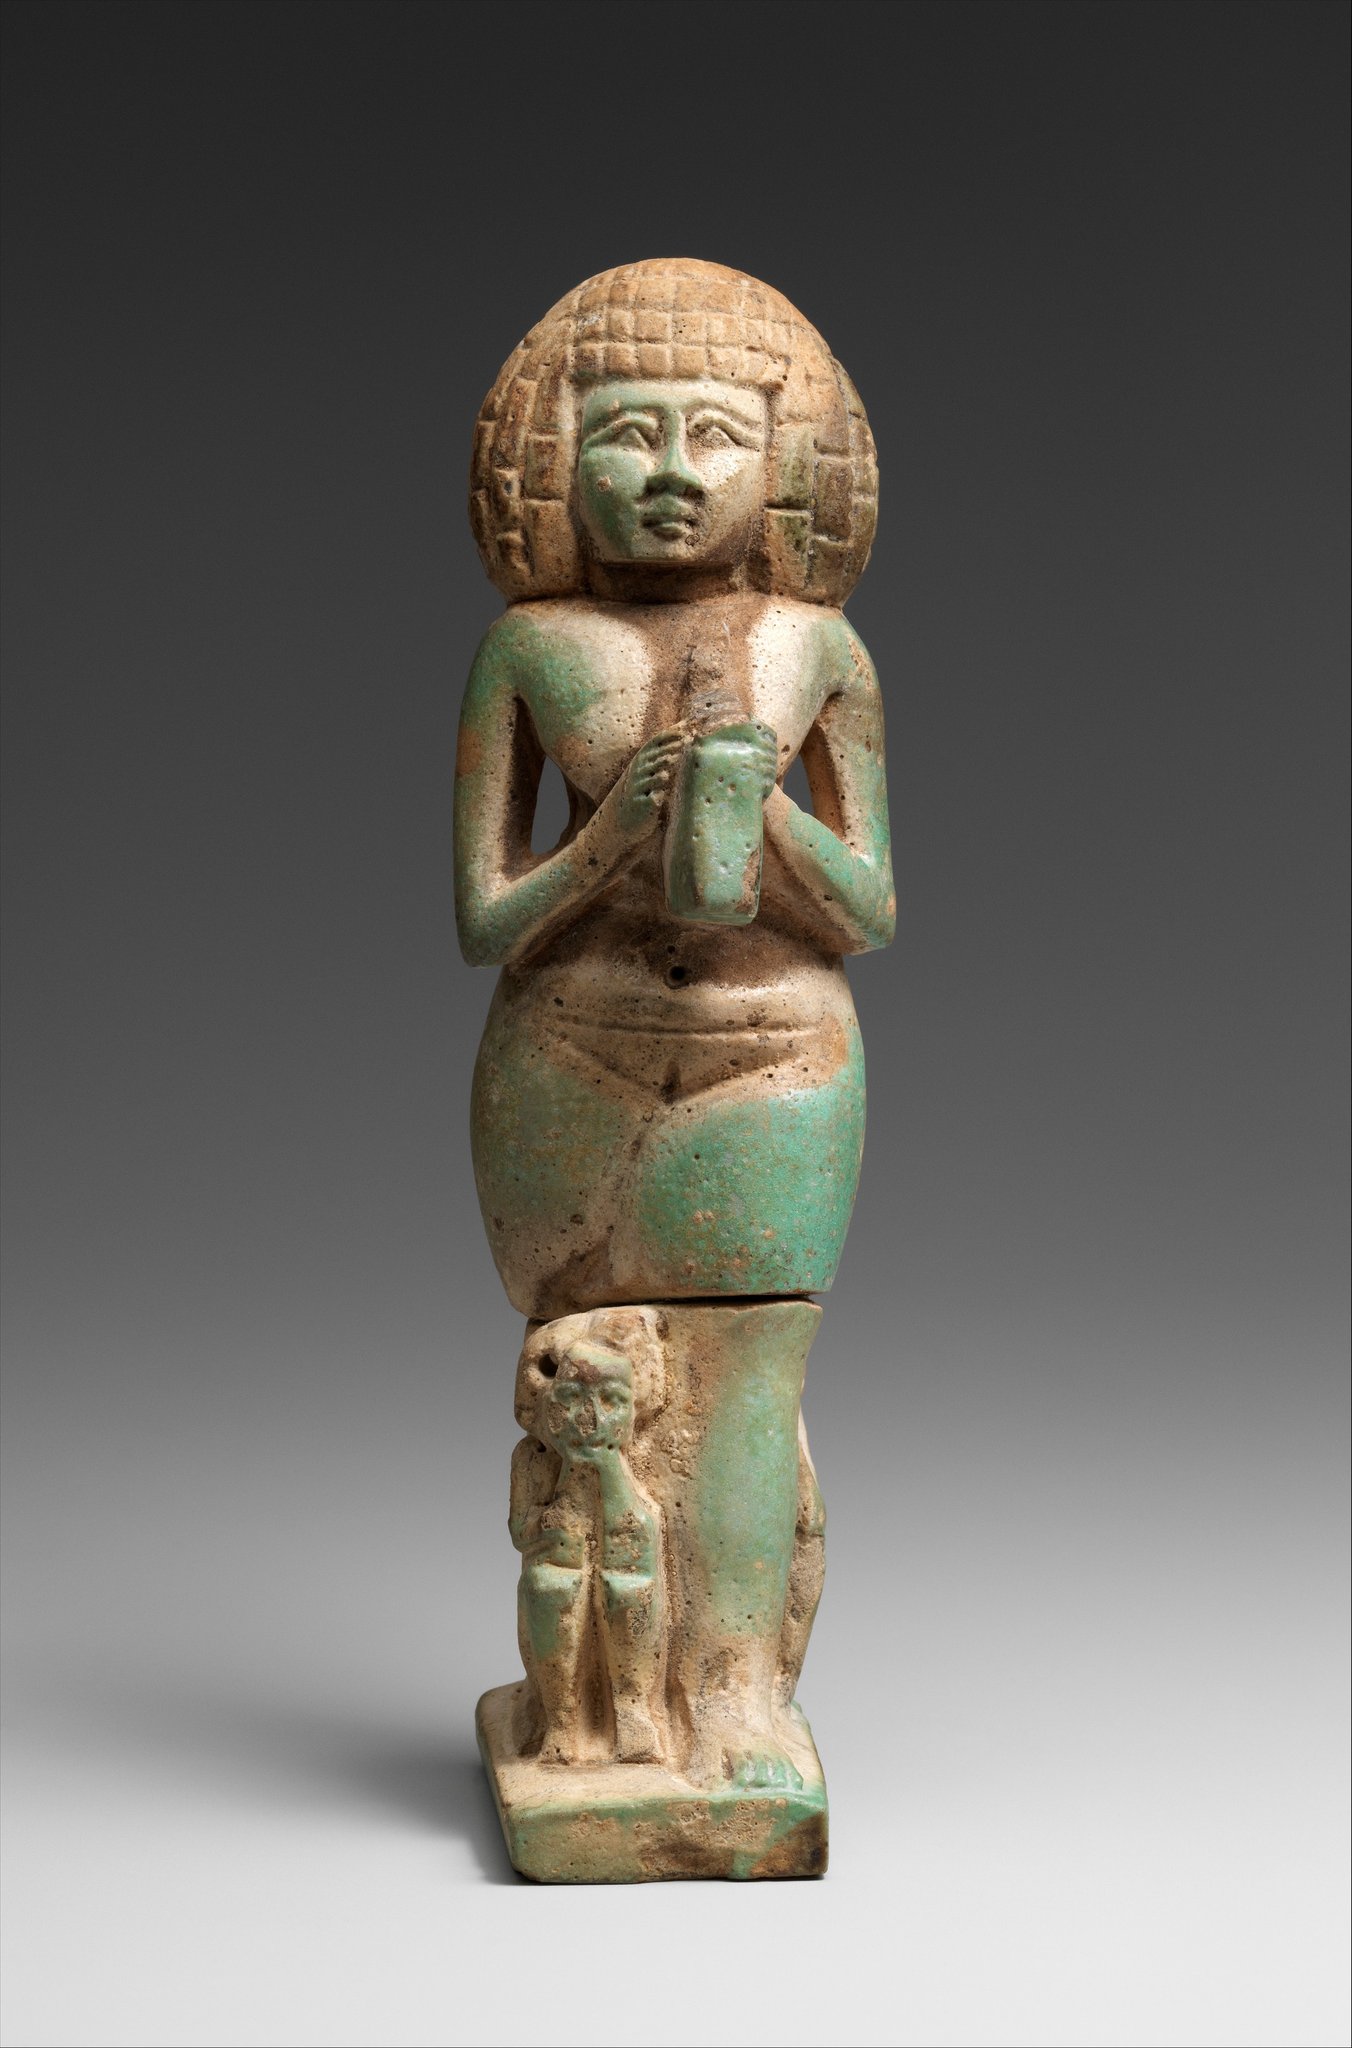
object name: statuette, woman, lyre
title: Woman with a lyre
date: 945-525 BCE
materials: faience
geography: egypt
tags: musical instruments,women